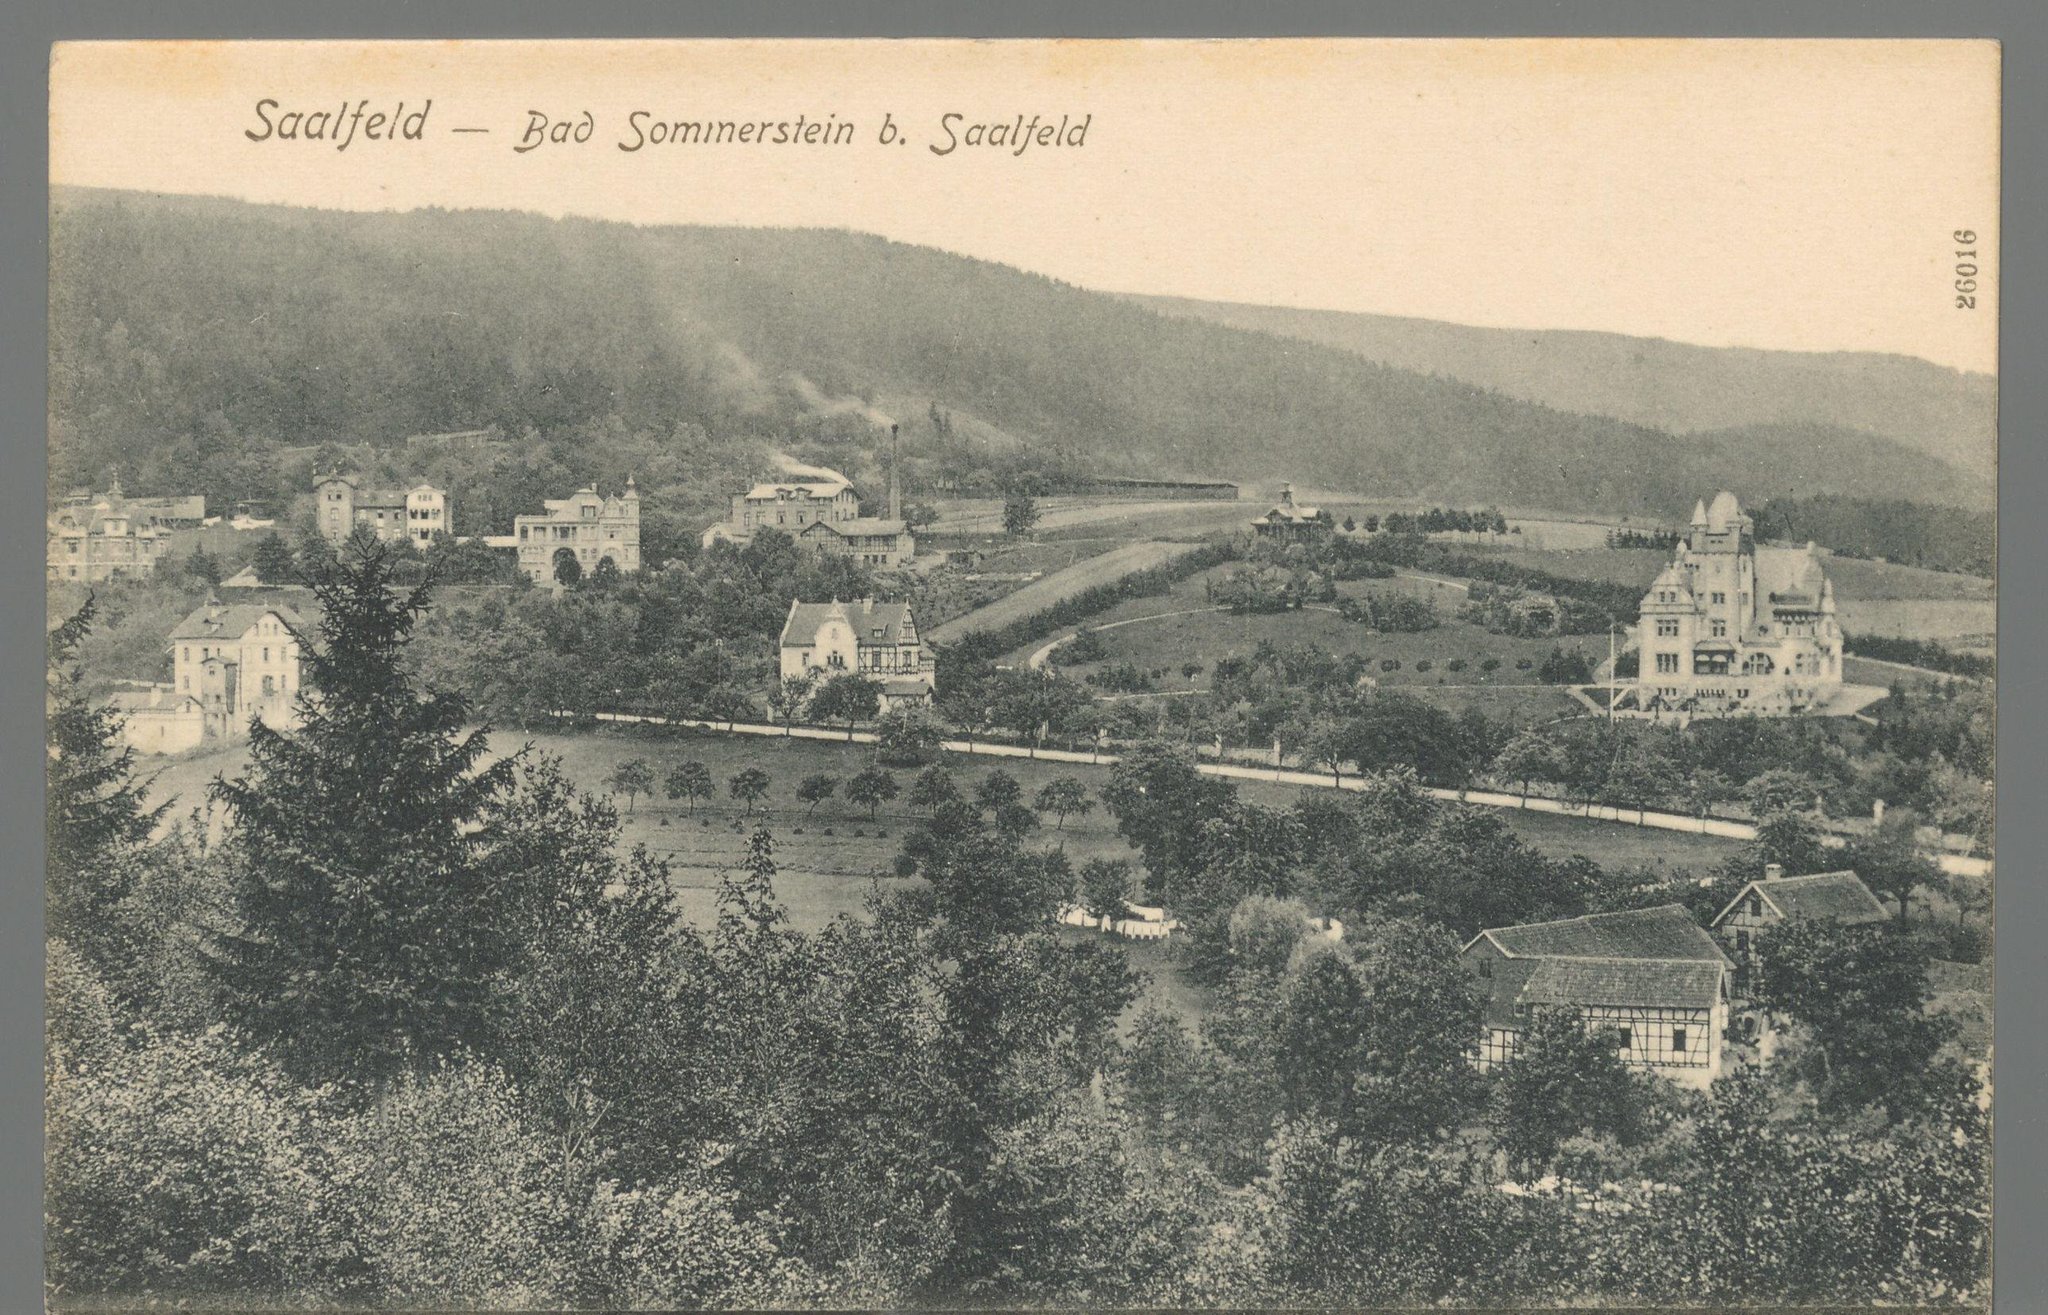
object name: photomechanical print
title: Saalfeld - Bad Sommerstein b. Saalfeld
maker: Anonymous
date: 1908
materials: cardboard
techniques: photograph, writing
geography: magdeburg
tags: city-view, and landscape with man-made constructions, mountains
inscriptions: date